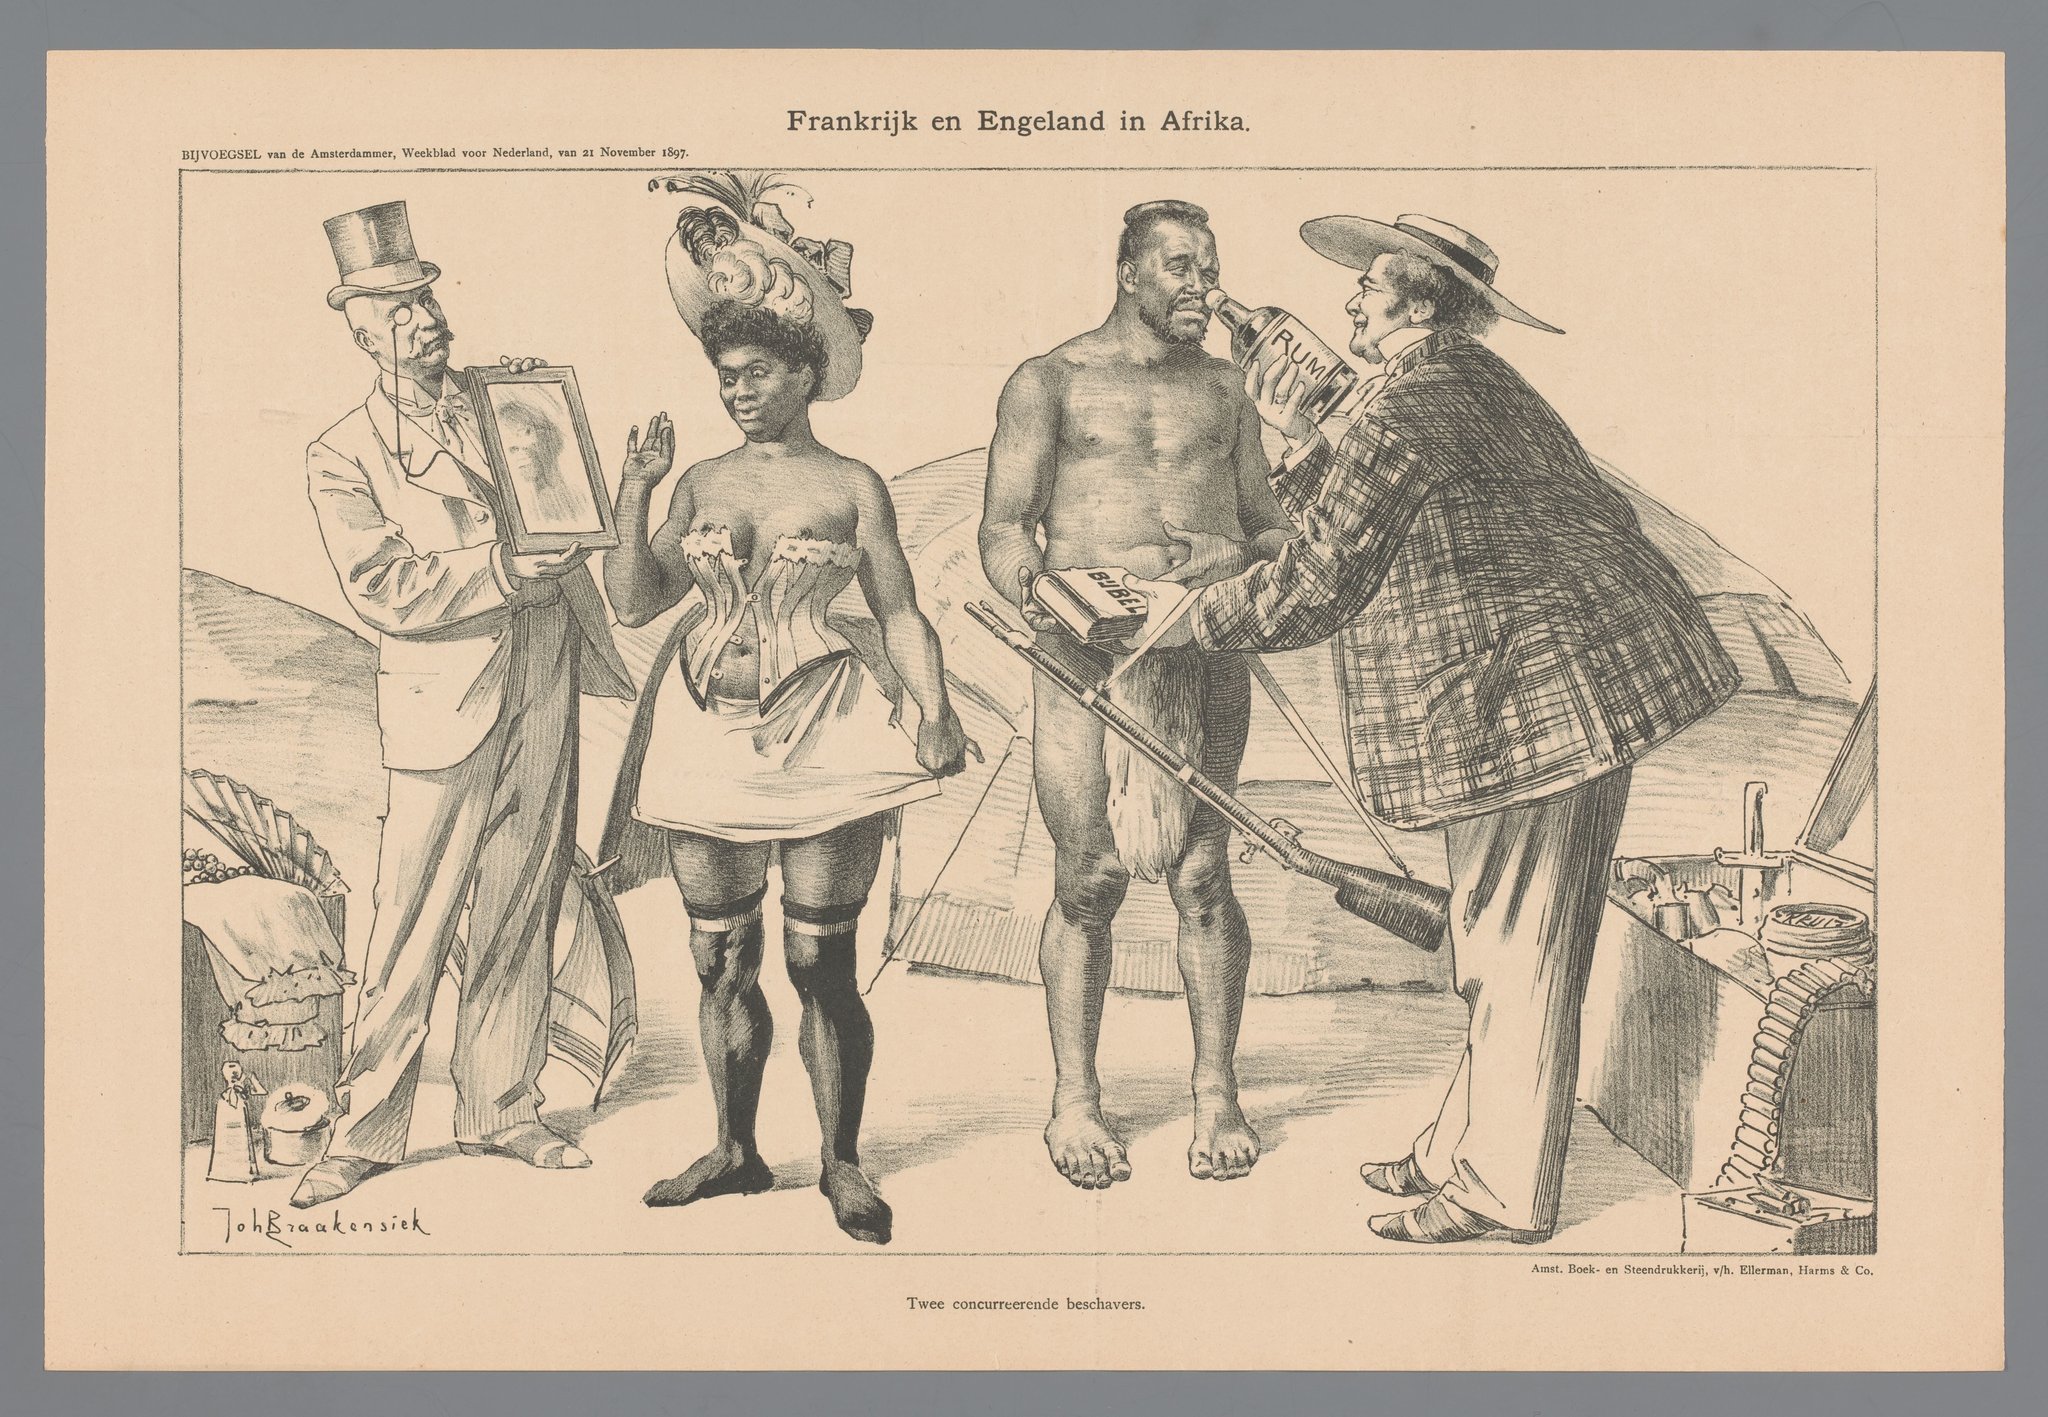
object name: cartoon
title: Frankrijk en Engeland in Afrika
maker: johan braakensiek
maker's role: draughtsman, print maker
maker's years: 1858-1940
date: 1897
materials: paper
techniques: lithograph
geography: amsterdam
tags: paris, colonial system, other alcoholic drinks, looking in the mirror; contemplation of own beauty, weapons, personifications of countries, nations, states, districts, etc. (+ nation; national), the bible as a book, political caricatures and satires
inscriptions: date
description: Prent uit het bijvoegsel van: De Amsterdammer. Weekblad voor Nederland, 21 november 1897.